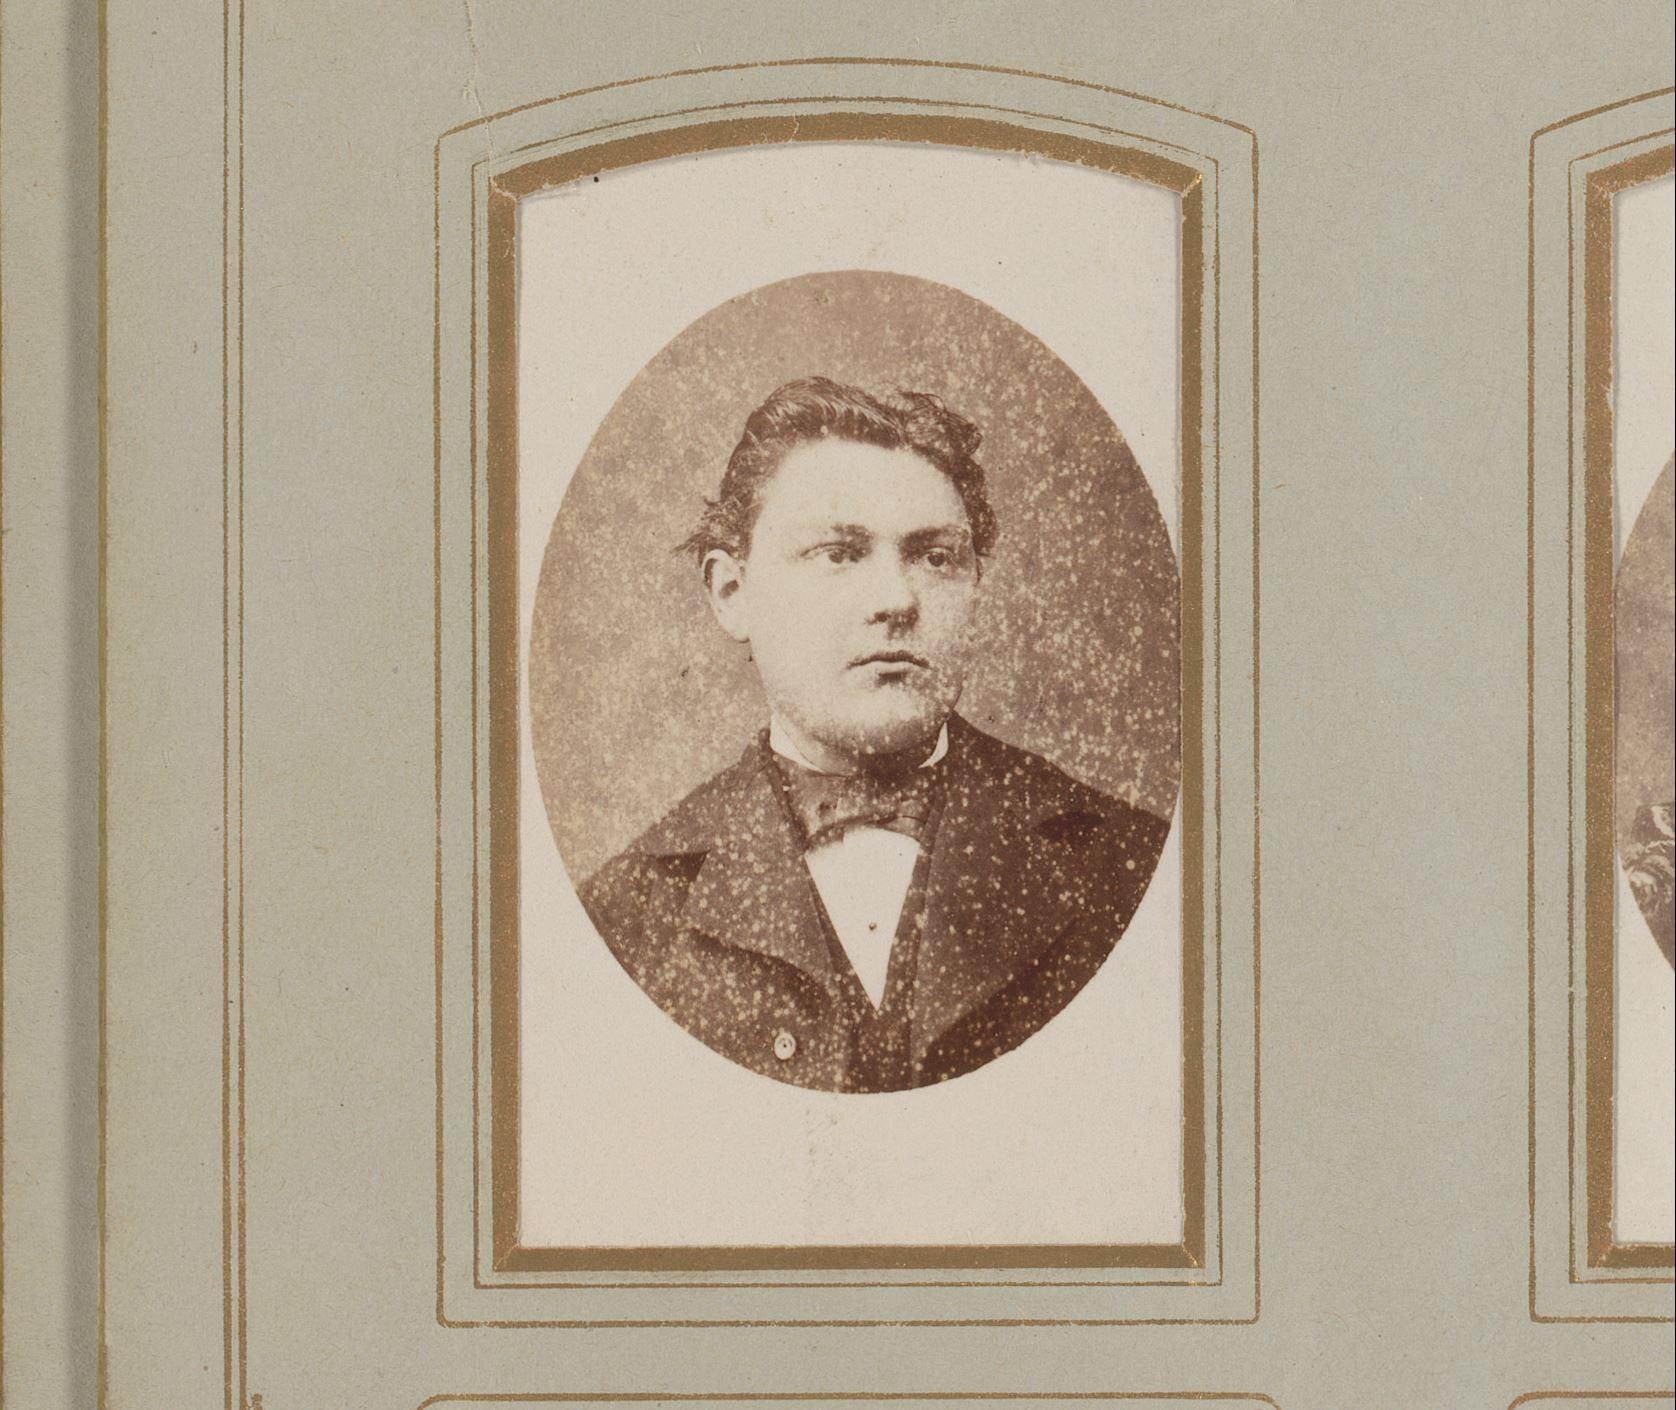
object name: photograph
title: Portret van een jonge man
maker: nicolaas jelles van ulsen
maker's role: fotograaf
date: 1880-1884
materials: cardboard, photographic support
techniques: albumen print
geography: purmerend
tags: historical persons, youth, adolescent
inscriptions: inscription: ‘N. J. VAN ULSEN/ PHOTOGRAAF/ KERKSTRAAT/ over de R.C.Kerk 95/ PURMEREND.’